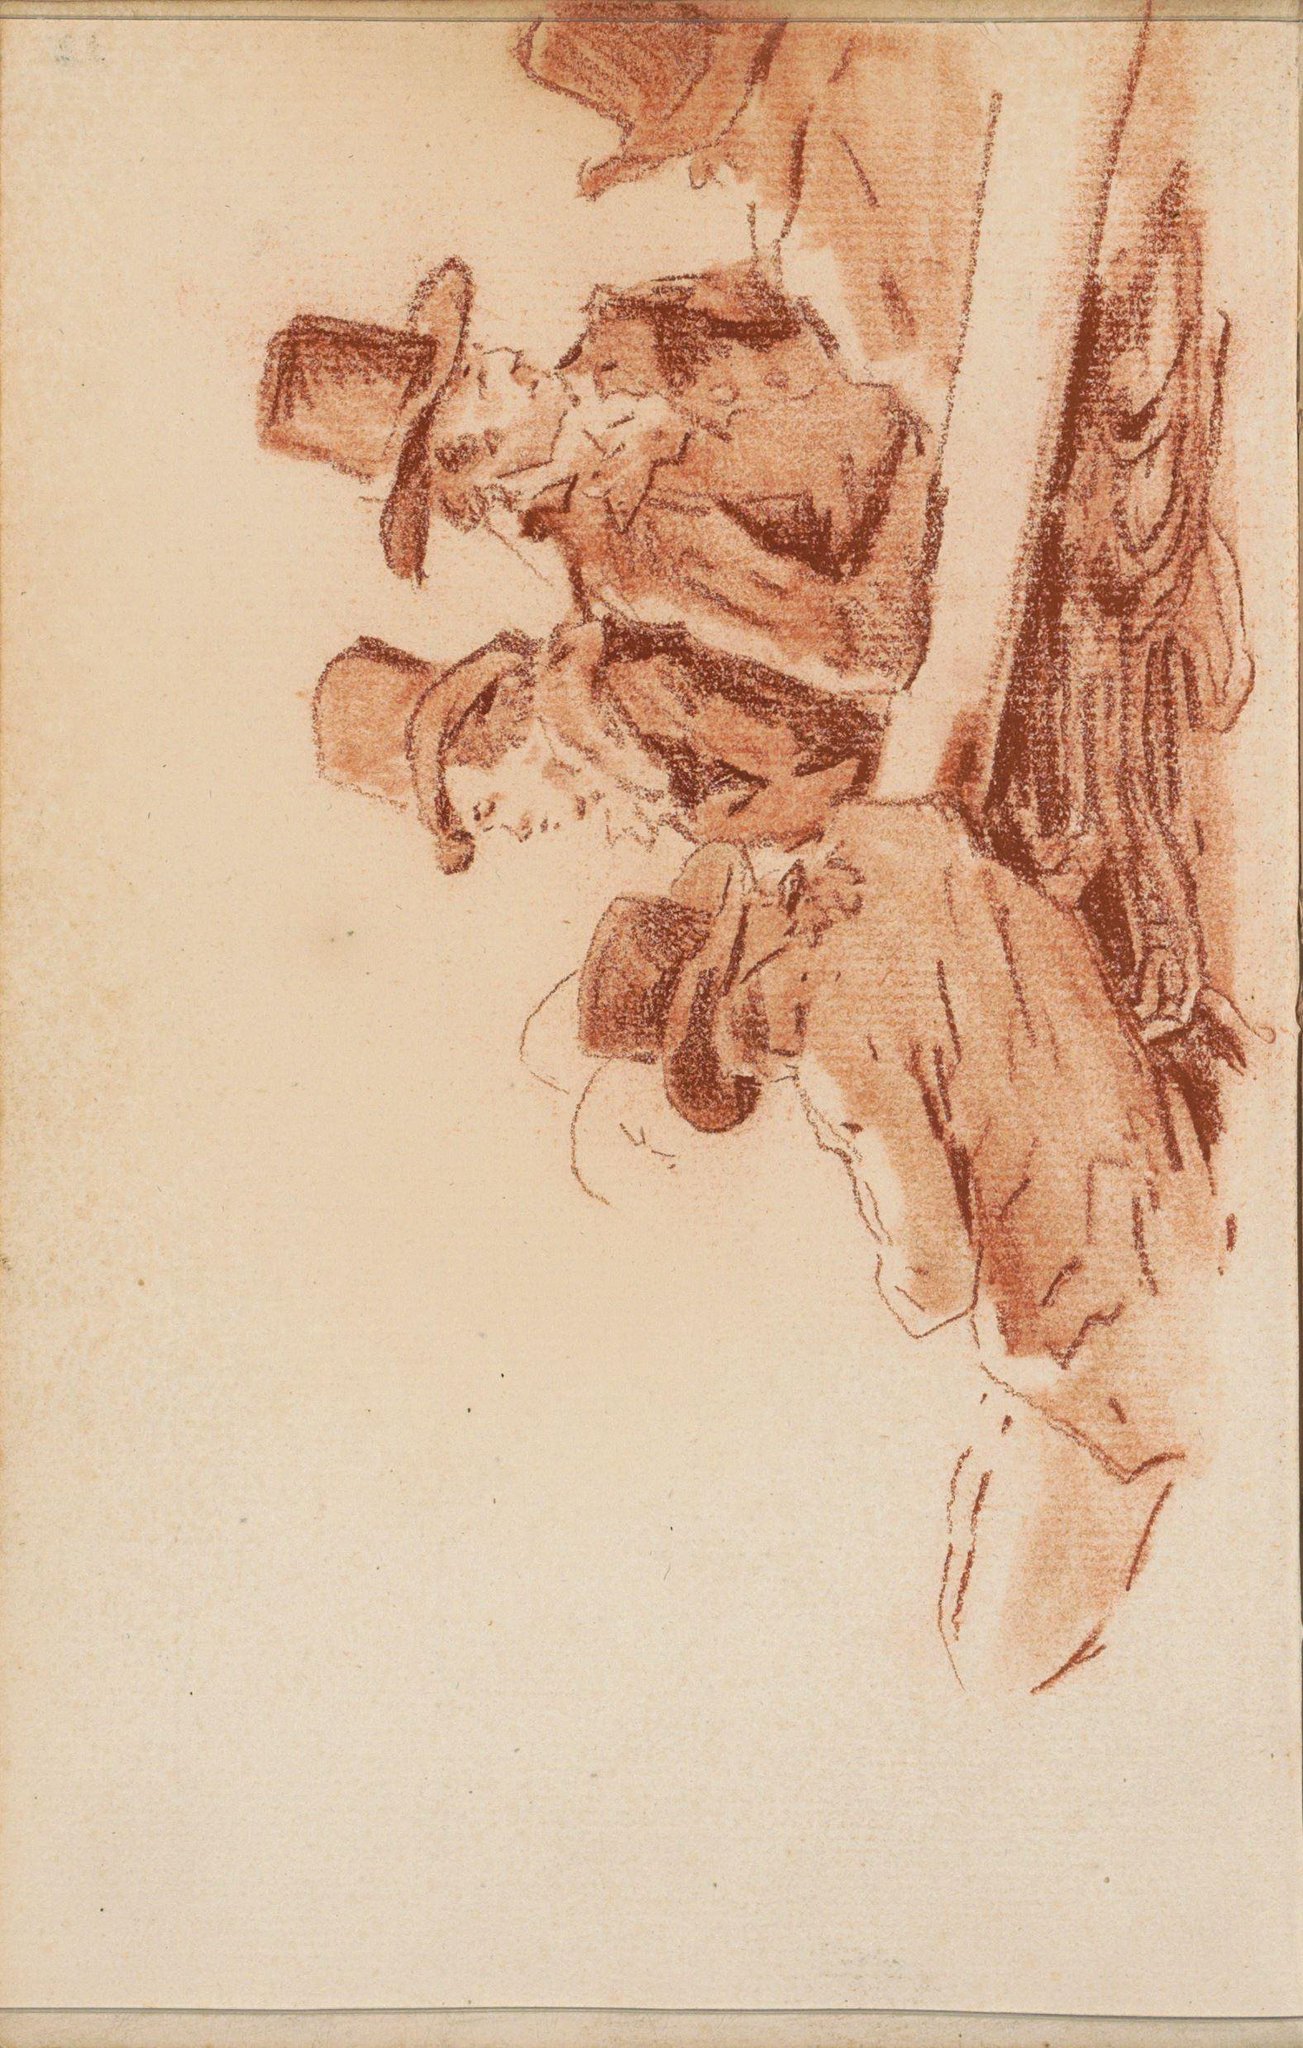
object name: sketchbook leaf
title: Vier mannen zittend op een bank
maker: jacob perkois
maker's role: draughtsman, print maker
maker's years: 1756-1804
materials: chalk, paper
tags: sitting figure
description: De mannen dragen hoge hoeden en een overjassen. Bladzijde 22 uit een schetsboek met 78 bladzijden.